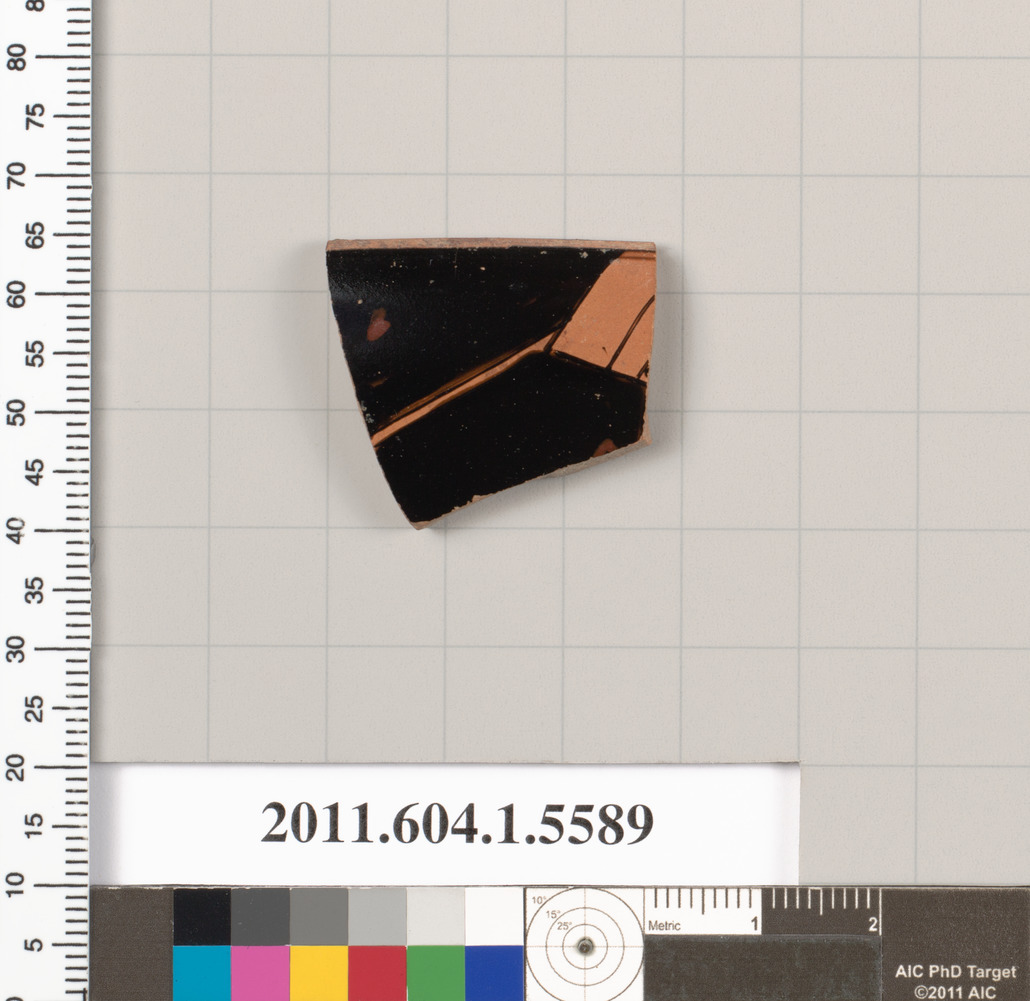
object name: kylix fragment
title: Terracotta rim fragment of a kylix (drinking cup)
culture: greek, attic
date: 500-480 BCE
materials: terracotta